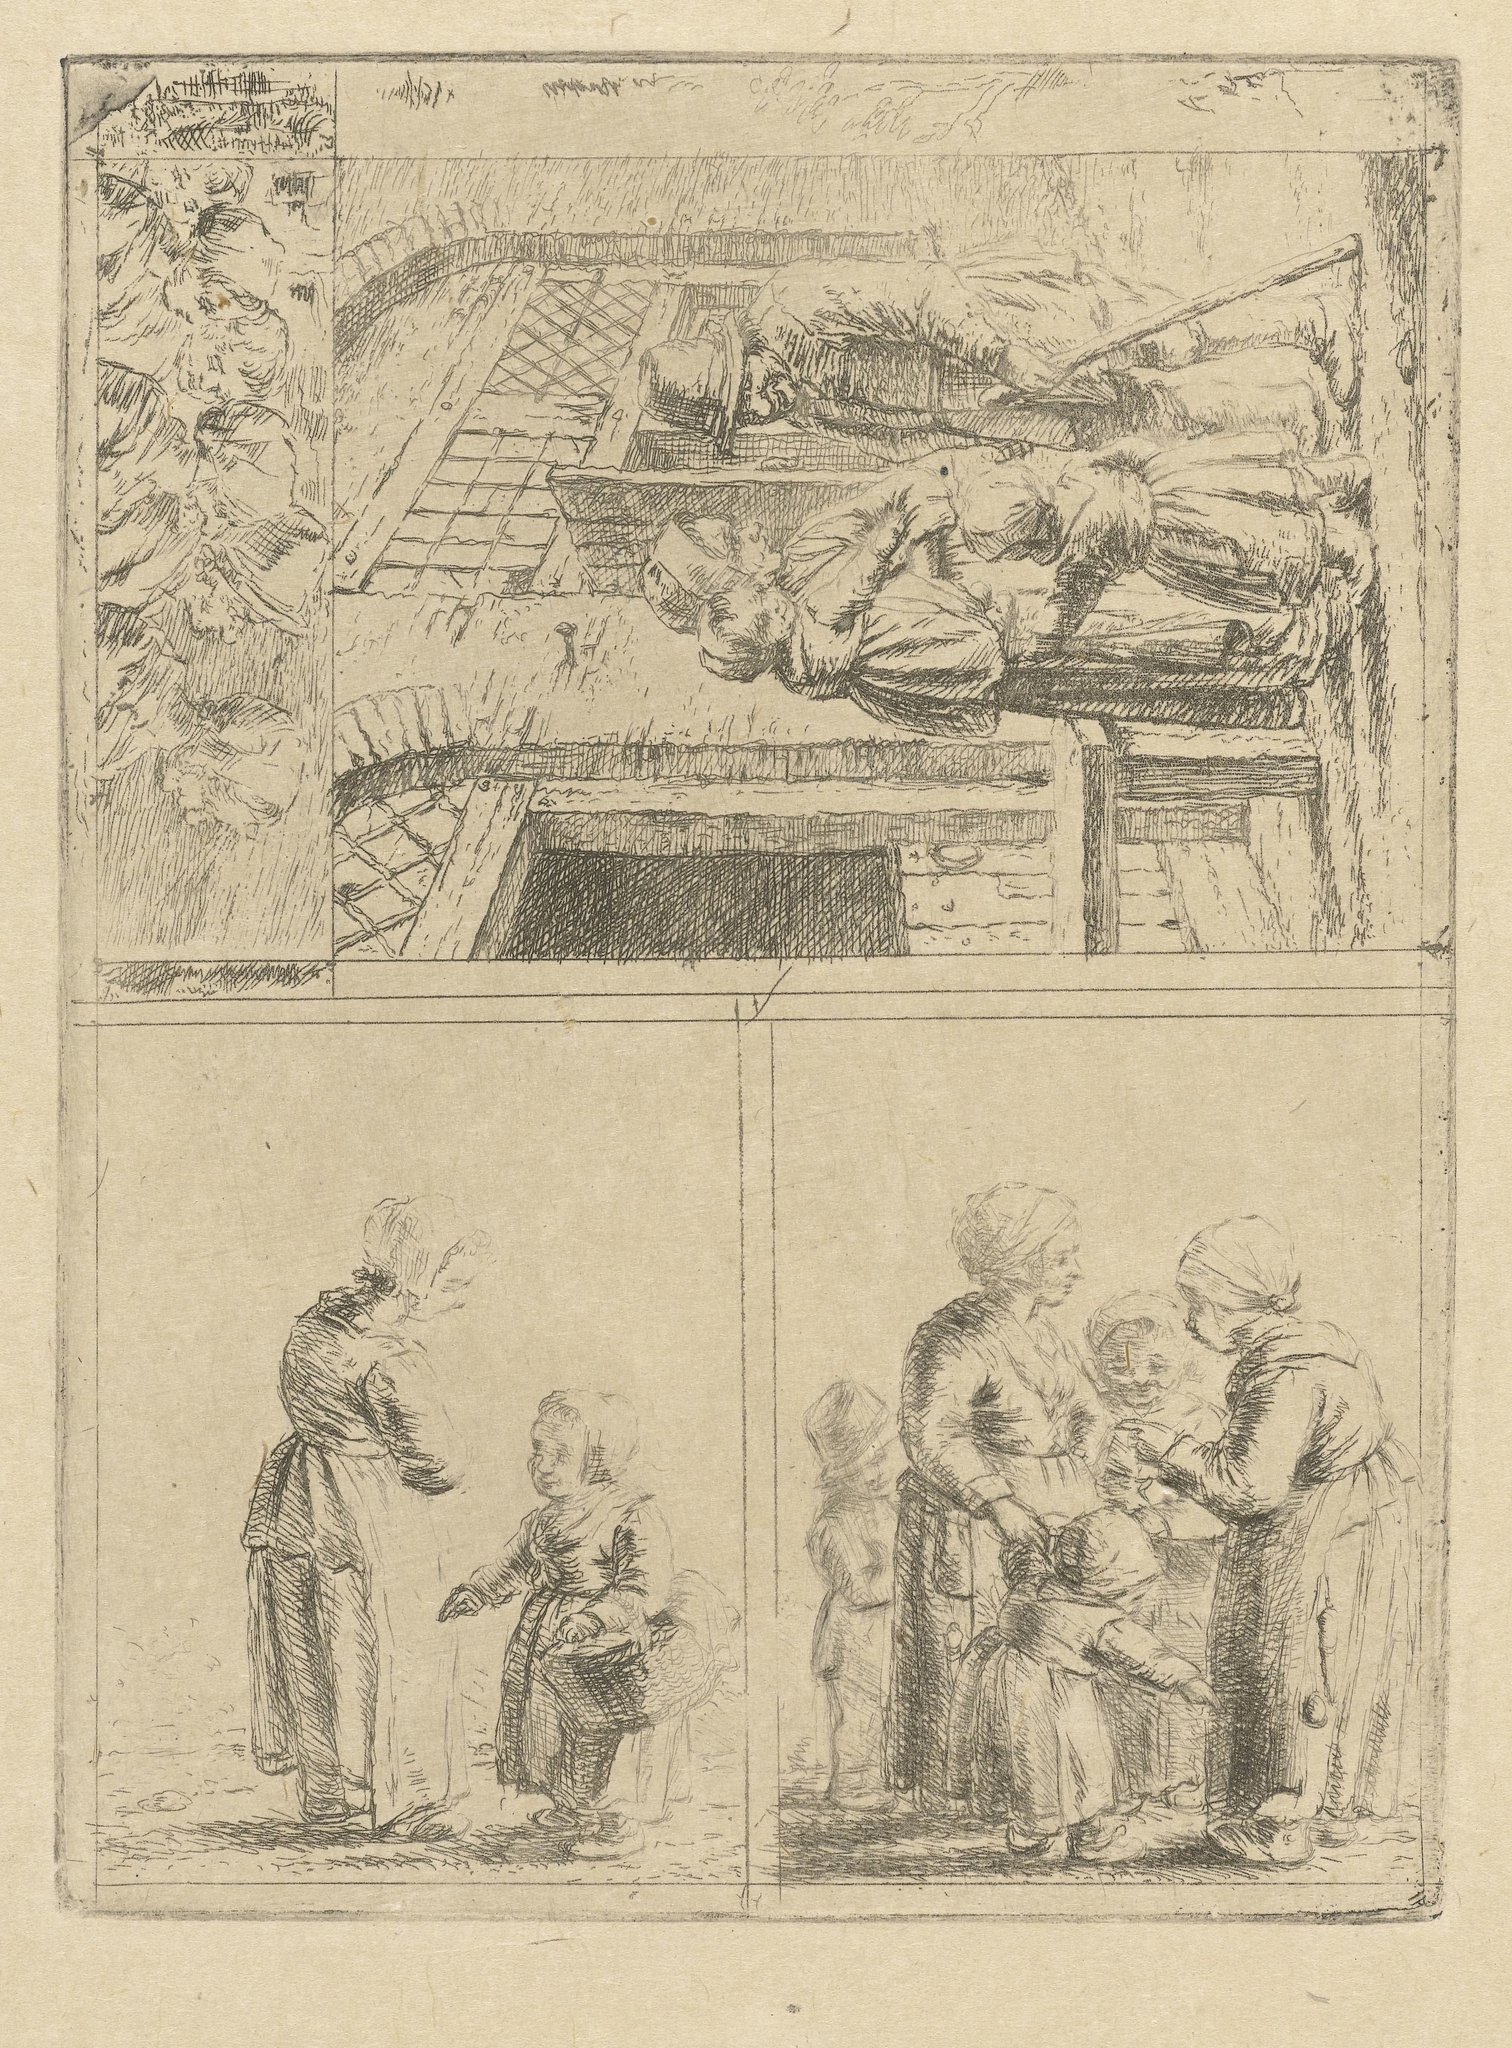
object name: print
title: Vier voorstellingen van het gezinsleven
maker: christina chalon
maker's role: draughtsman, print maker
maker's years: 1748-1808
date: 1758-1808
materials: paper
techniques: etching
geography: leiden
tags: carrying something in basket, bag, rucksack, etc., human races; peoples; nationalities (+ women), family group, especially parents with their child(ren) (with number of children), the (nude) human figure; 'corpo humano' (ripa) (+ young female (human being))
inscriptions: collector's mark: Lugt 240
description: Een onversneden blad met vier voorstellingen van het gezinsleven. In de eerste voorstelling staat een vrouw voor haar voordeur. Ze is in gesprek met haar man. Ze heeft haar dochtertje op de arm. Een tweede dochtertje staat naast de vader. Een tweede voorstelling is van twee meisjes. De jongste heeft een mand om de arm. De derde voorstelling is van drie vrouwen. Ze staan bij elkaar en zijn druk in gesprek. Een van de vrouwen heeft een kind aan de hand. Een ander kind verschuild zich achter haar rok. De vierde en laatste voorstelling toont de bustes van vier vijf personen in zijaanzicht (buste naar rechts). De portretten zijn van twee mannen en drie vrouwen.